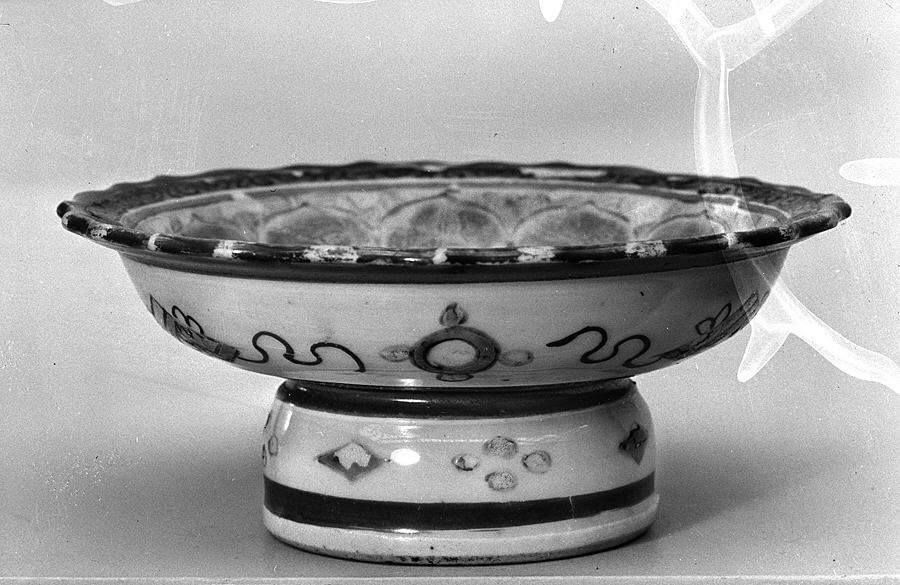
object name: dish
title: Foliated dish with lotus design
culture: chinese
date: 1801-1900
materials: enamel, porcelain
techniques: overglaze, painting, polychrome